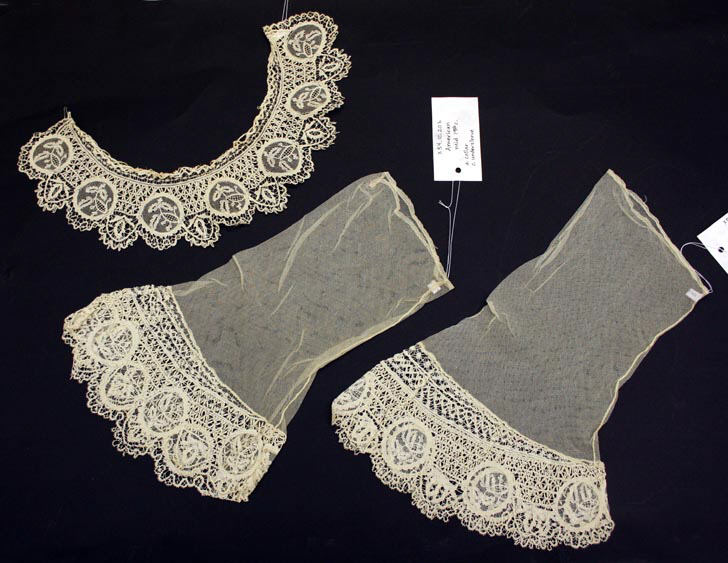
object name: accessory set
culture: american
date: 1834-1866